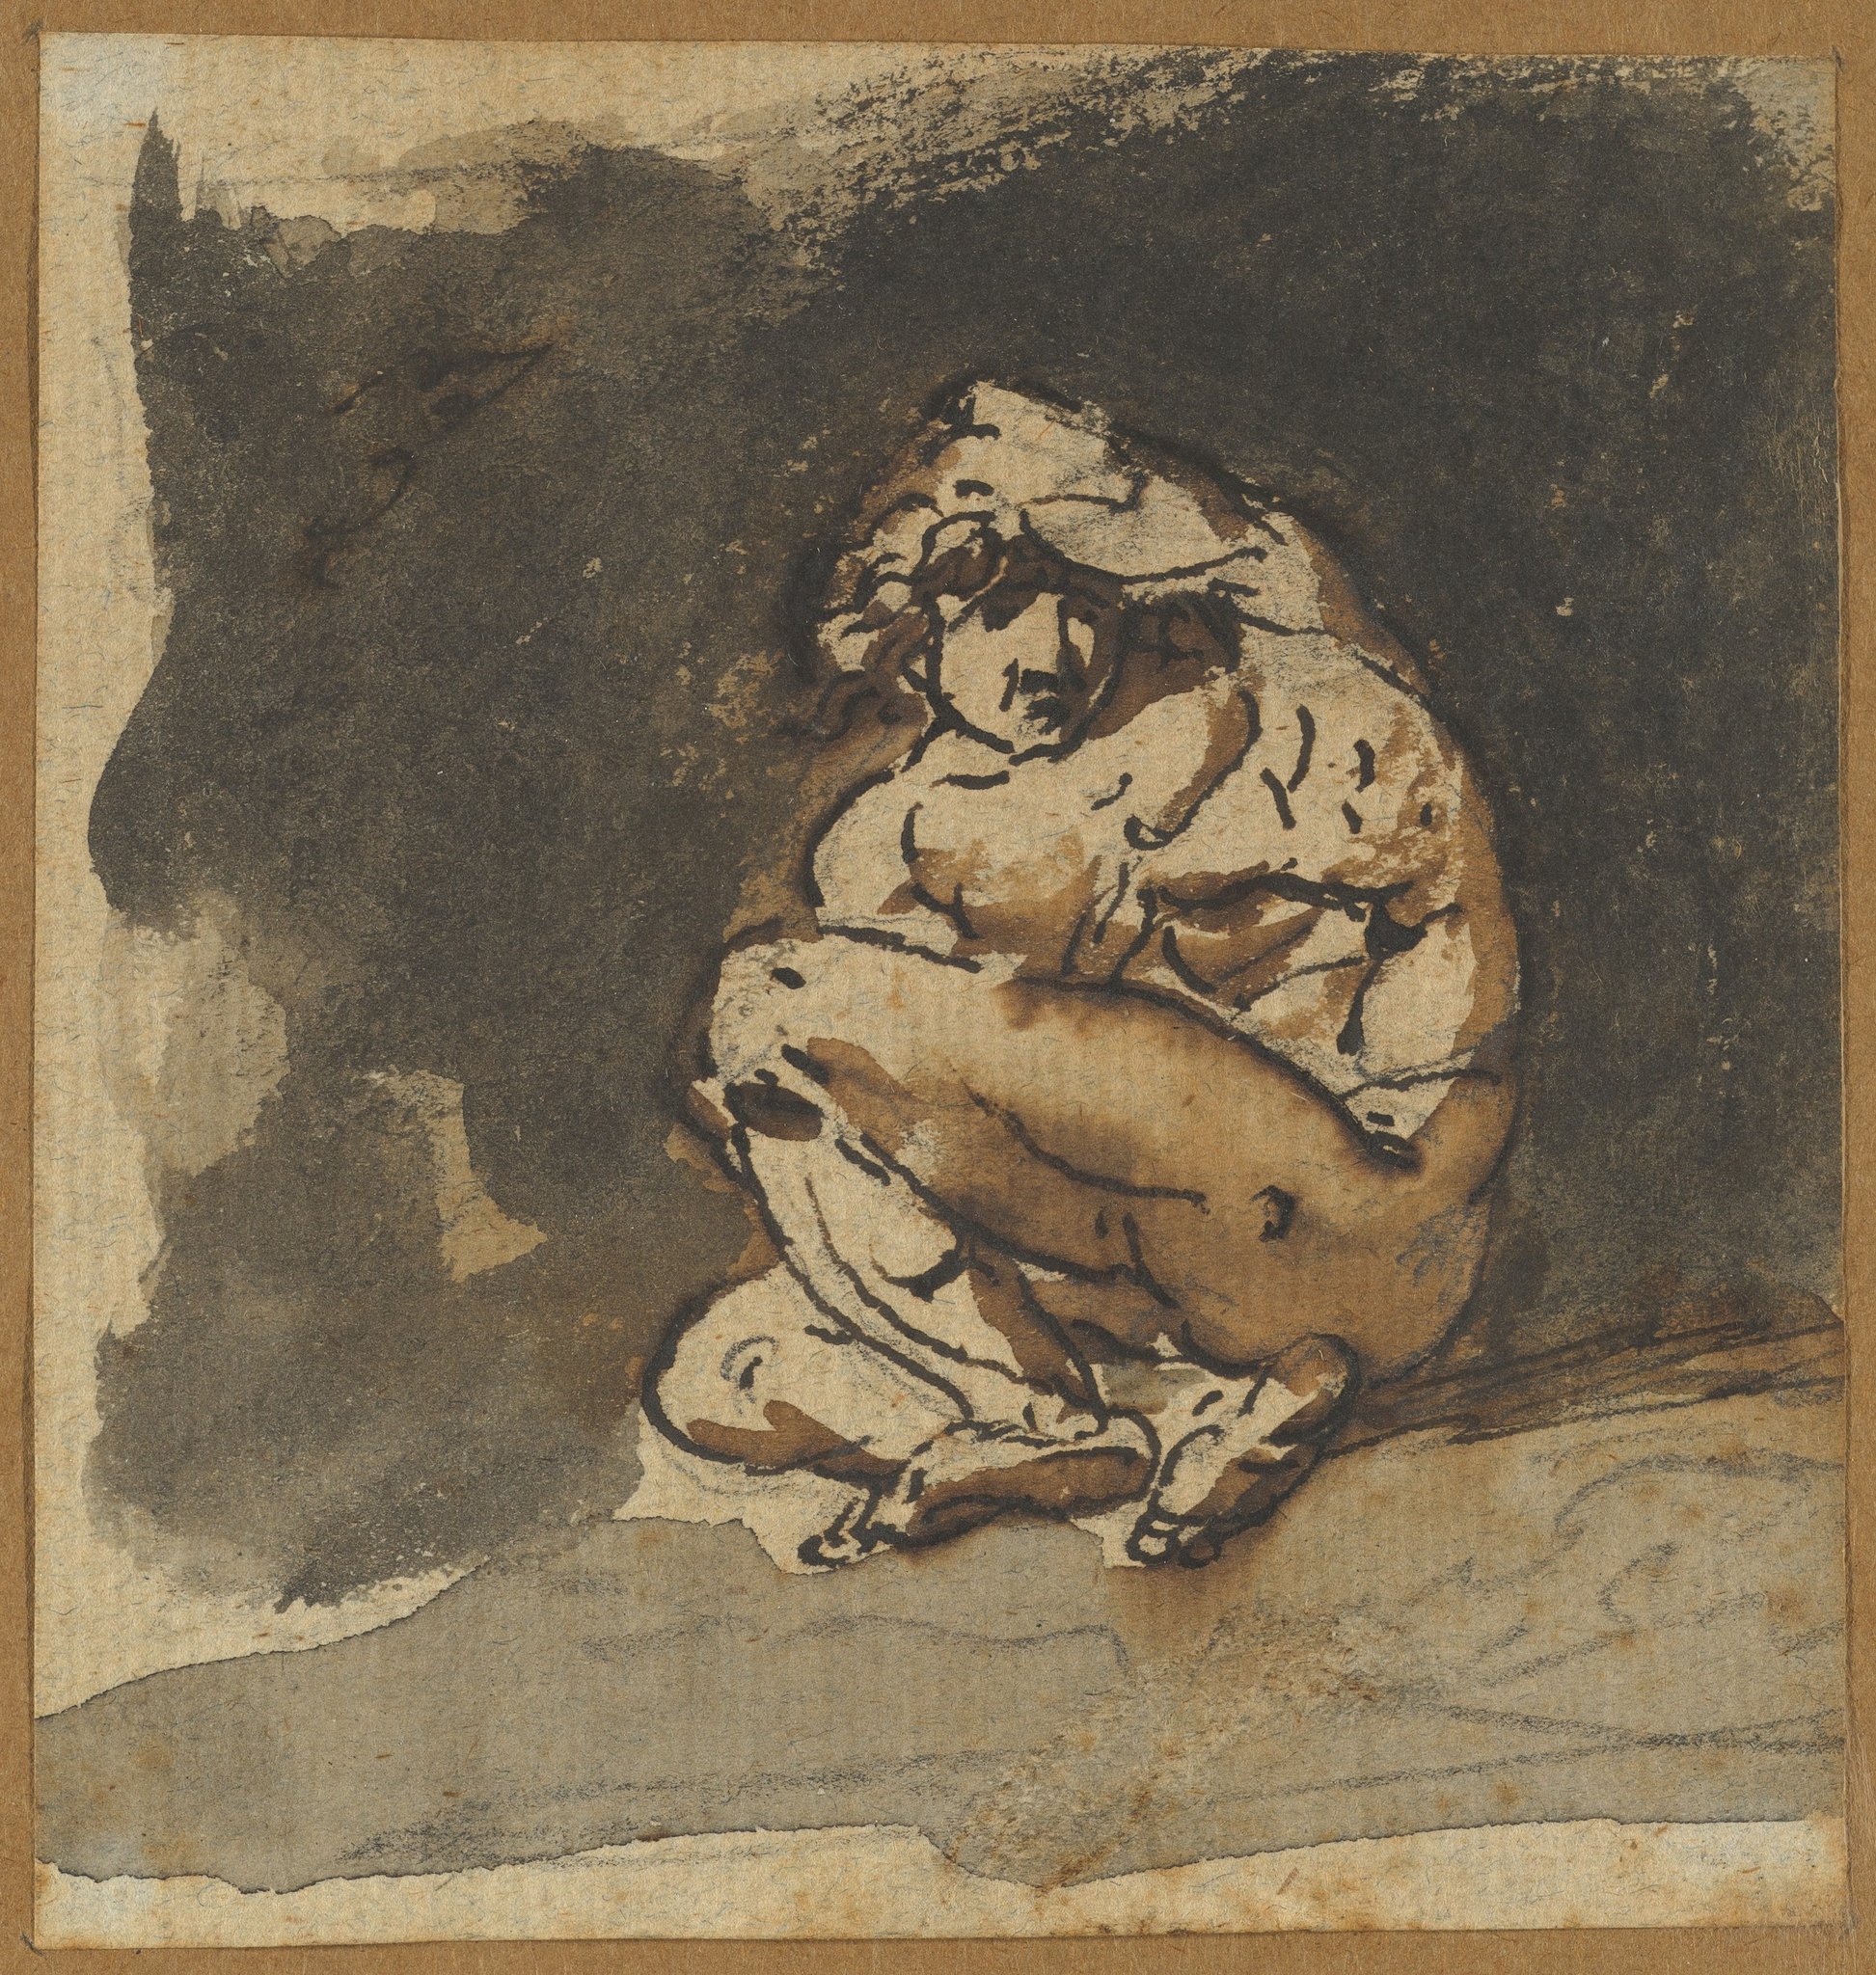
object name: drawing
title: Study of a Male Nude (Althaemenes) Trying to Hide Himself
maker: nicolai abraham abildgaard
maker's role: artist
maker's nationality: danish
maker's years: 1743-1809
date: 1734-1833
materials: graphite, ink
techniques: pen, wash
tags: male nudes